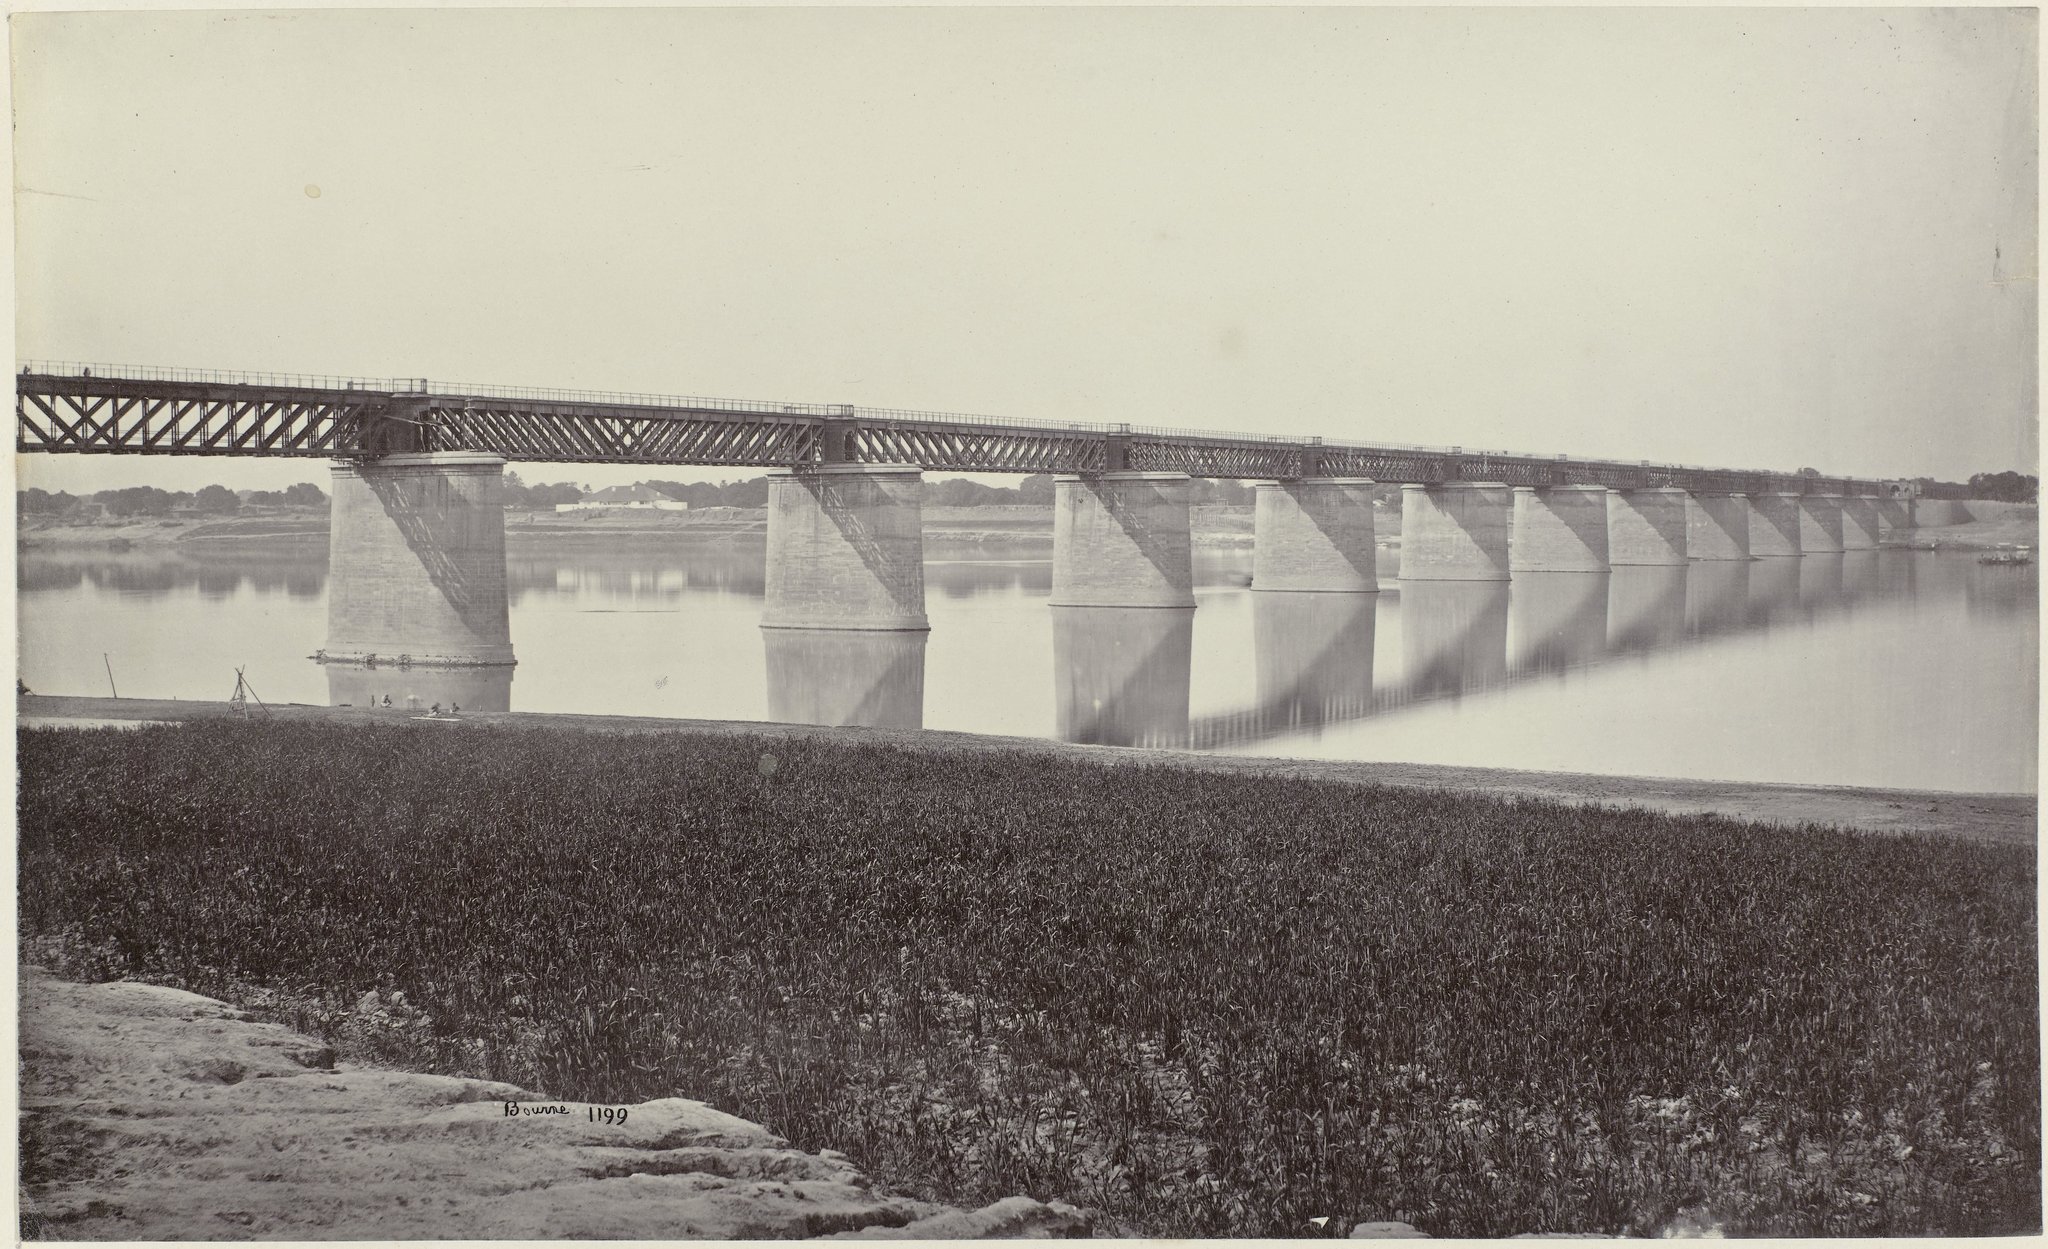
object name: album leaf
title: Railway bridge across the Yamuna river at Prayagraj (Allahabad), Uttar Pradesh, India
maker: samuel bourne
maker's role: fotograaf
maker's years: 1834-1912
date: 1865-1874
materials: paper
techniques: albumen print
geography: allahabad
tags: river, bridge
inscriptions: number: ‘1199’, inscription: ‘Inman Bridge Allahabad’, name: ‘Bourne’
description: Deze spoorbrug verbindt de oevers aan weerszijden van de Yamuna, net voordat de rivier de Ganges in stroomt. De brug werd voltooid in 1865 en geldt met zijn 1006 meter (3300 feet) als een grote prestatie van Britse techniek. Dankzij deze brug ontstond een verbinding tussen de spoorlijnen van Hooghly bij Kolkata aan de rechteroever en Yamuna bij Delhi, waardoor veerponten overbodig werden.